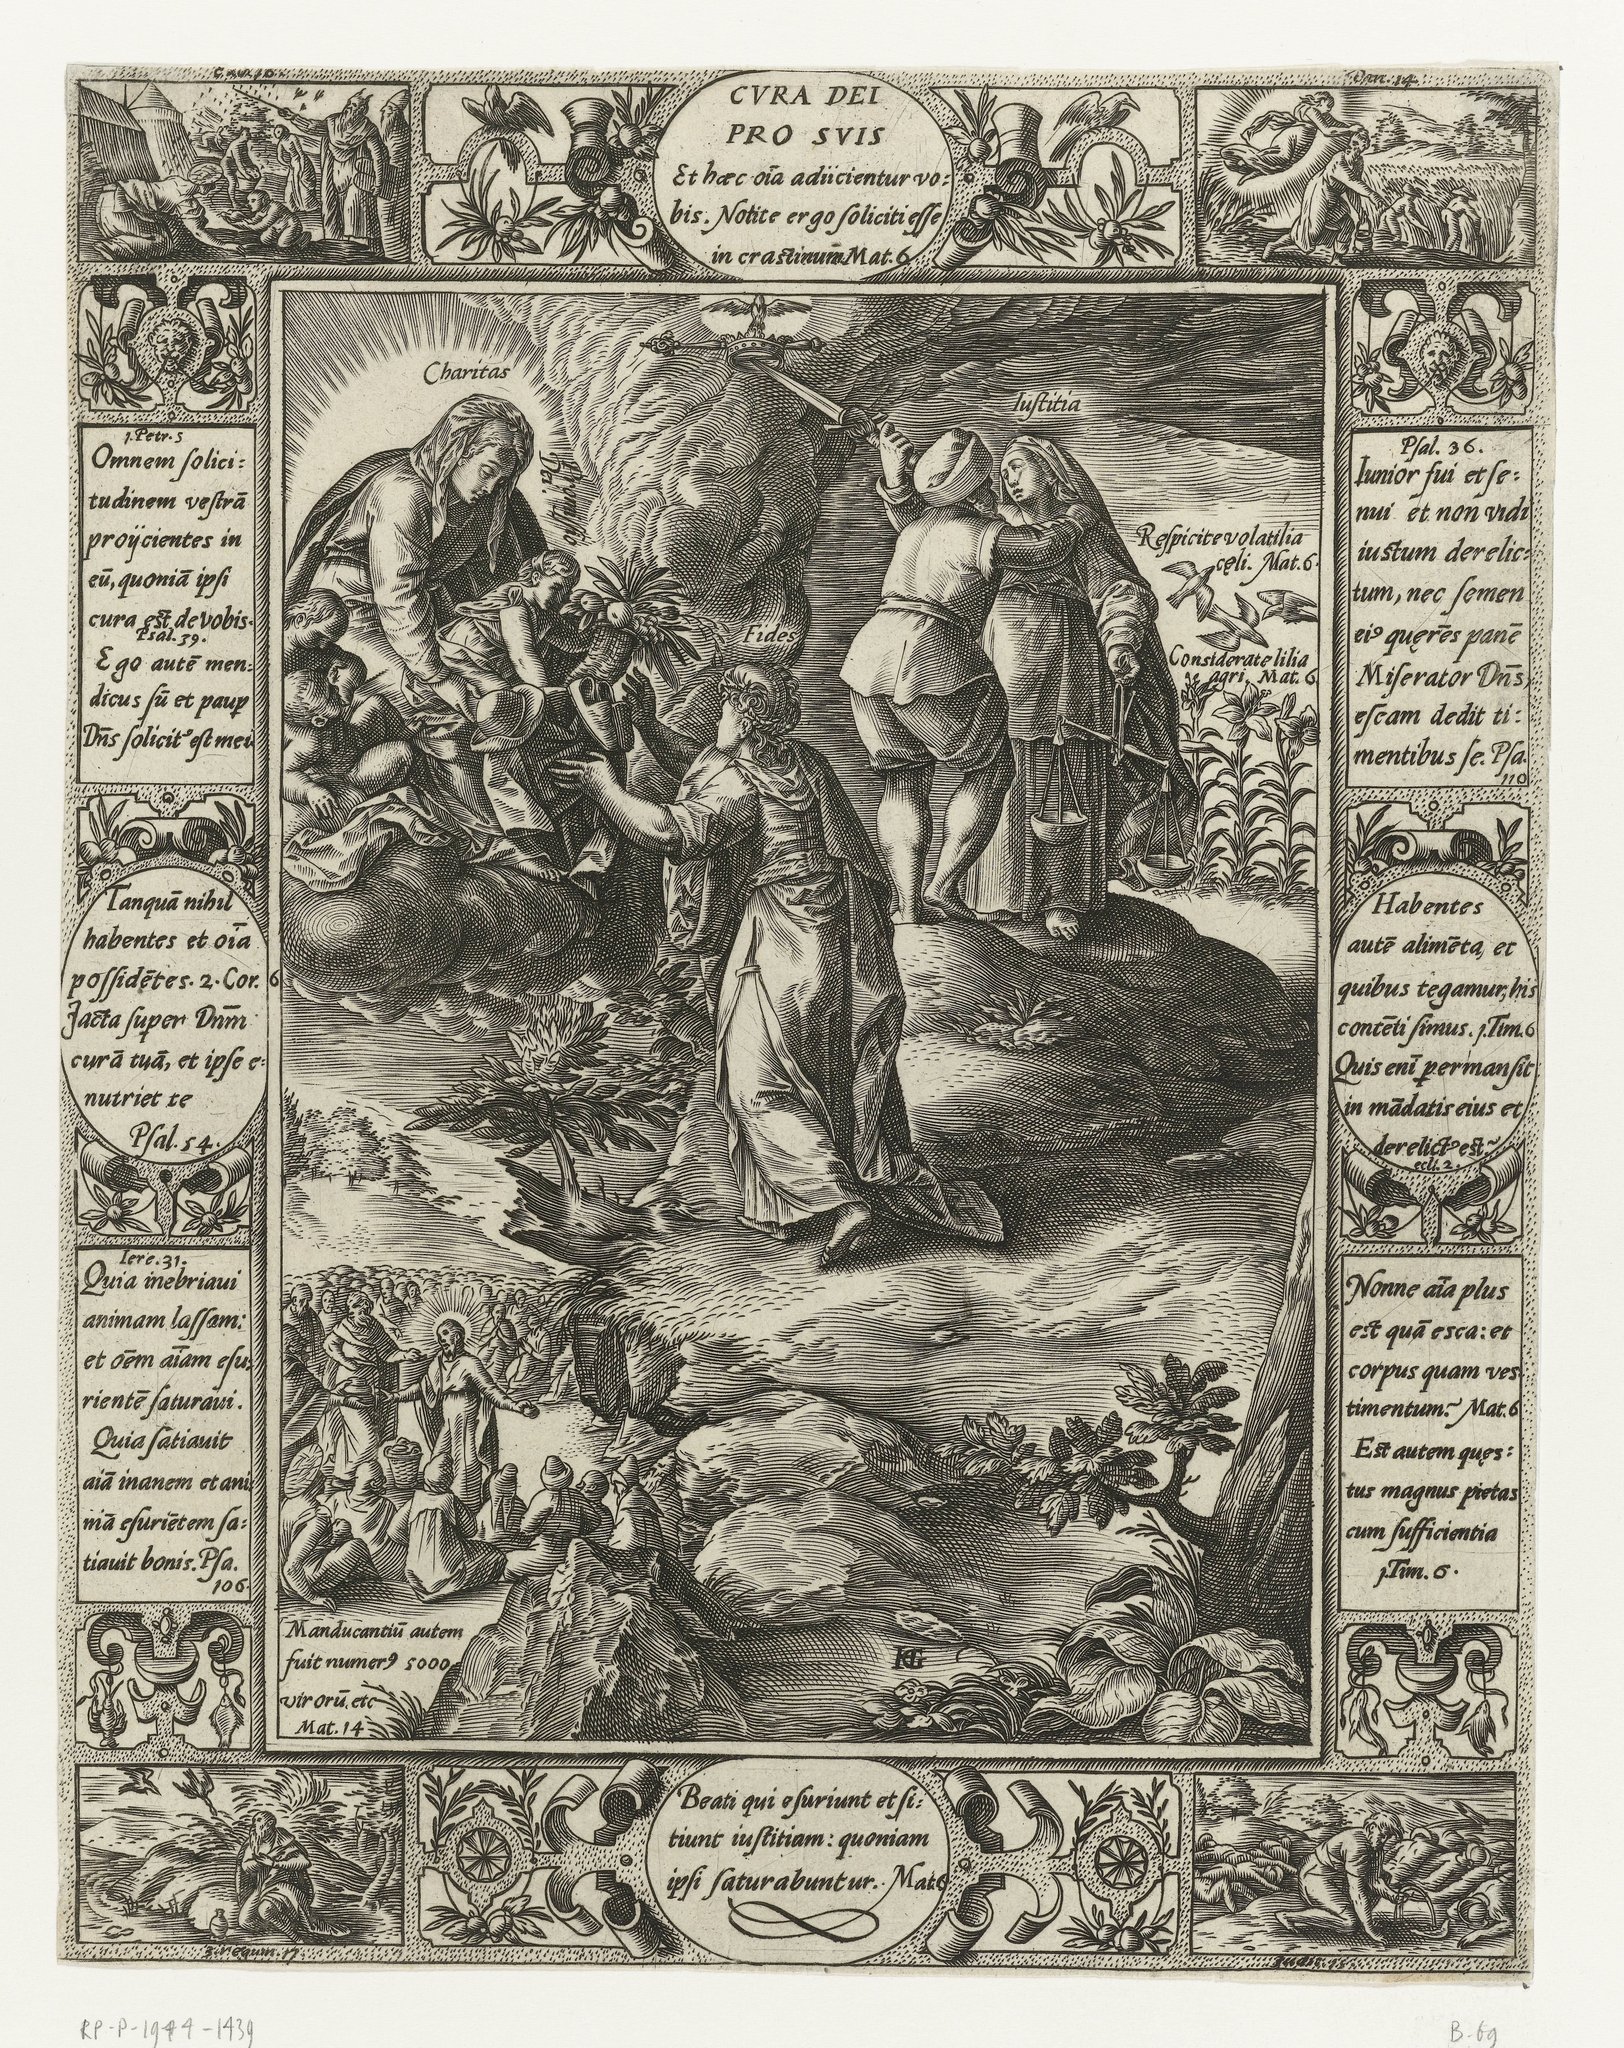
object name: print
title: Cura dei pro suis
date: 1598-1604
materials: paper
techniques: engraving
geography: the hague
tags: charity, 'caritas'; 'carità' (ripa) ~ one of the three theological virtues, justice, 'justitia'; 'giustitia divina' (ripa) ~ one of the four cardinal virtues, faith, 'fides'; 'fede', 'fede catholica', 'fede christiana', 'fede christiana catholica' (ripa) ~ one of the three theological virtues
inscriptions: collector's mark: Lugt 699, collector's mark: Lugt 2228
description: Allegorie met een centrale voorstelling met personificaties van de deugden Liefde (Caritas), Hoop (Fides) en Gerechtigheid (Justitia) met daaromheen een omlijsting waarin citaten uit de bijbel gecombineerd zijn met de verbeelding van bepaalde gebeurtenissen uit de bijbel.